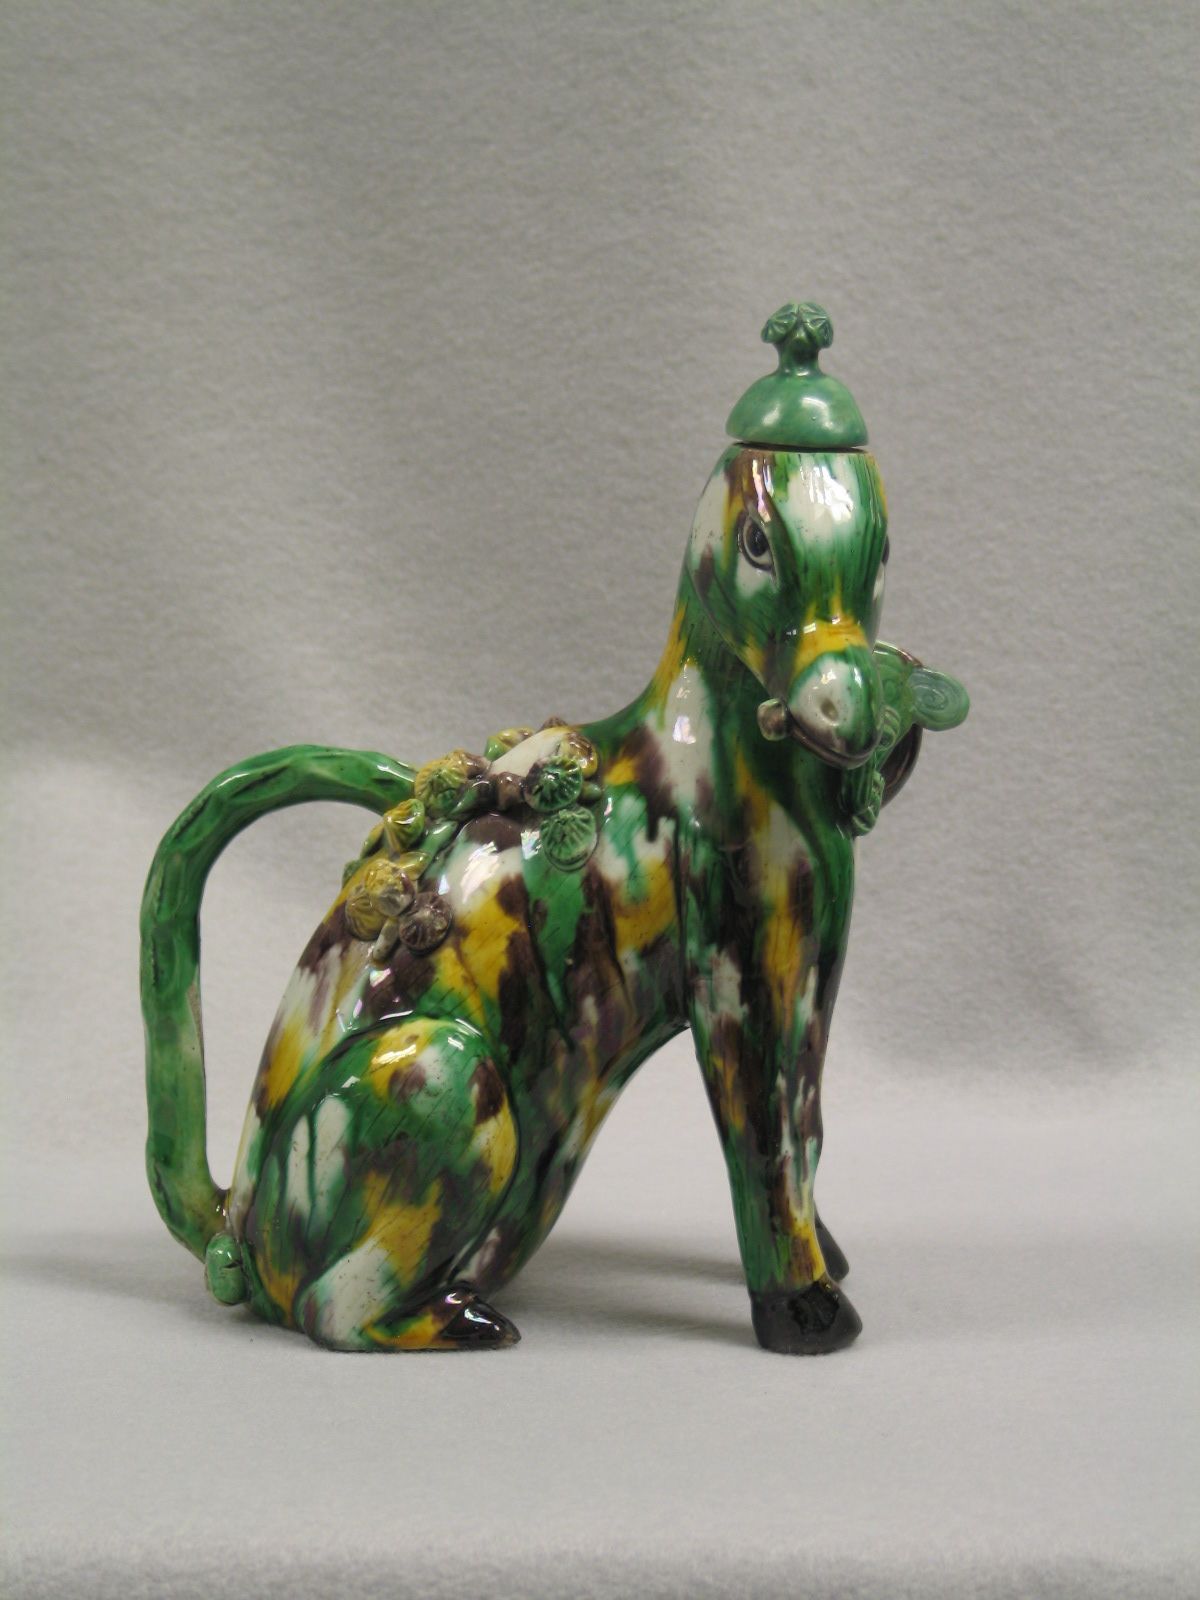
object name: vessel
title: Vessel in the form of a Deer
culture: chinese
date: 1667-1733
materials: glaze, porcelain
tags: deer